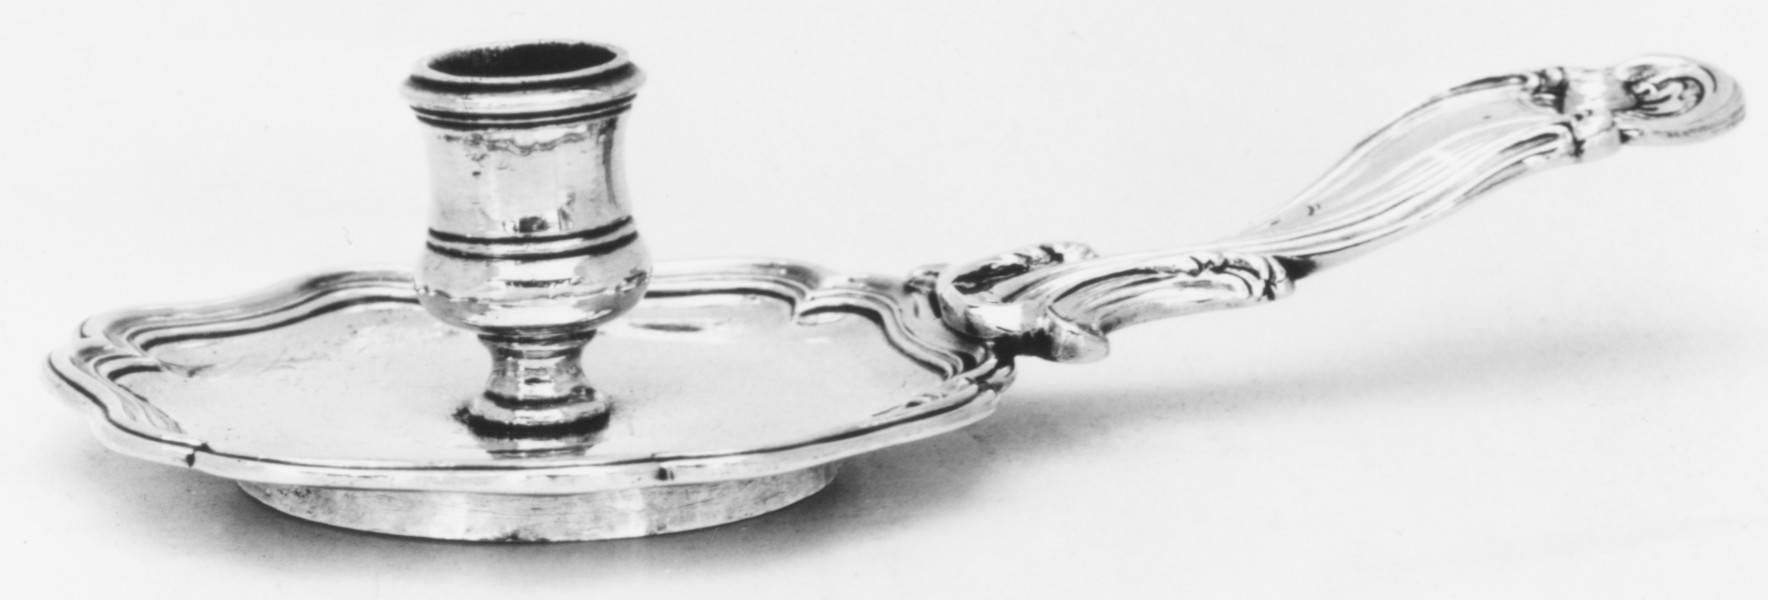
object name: chamber candlestick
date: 1734-1766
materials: silver